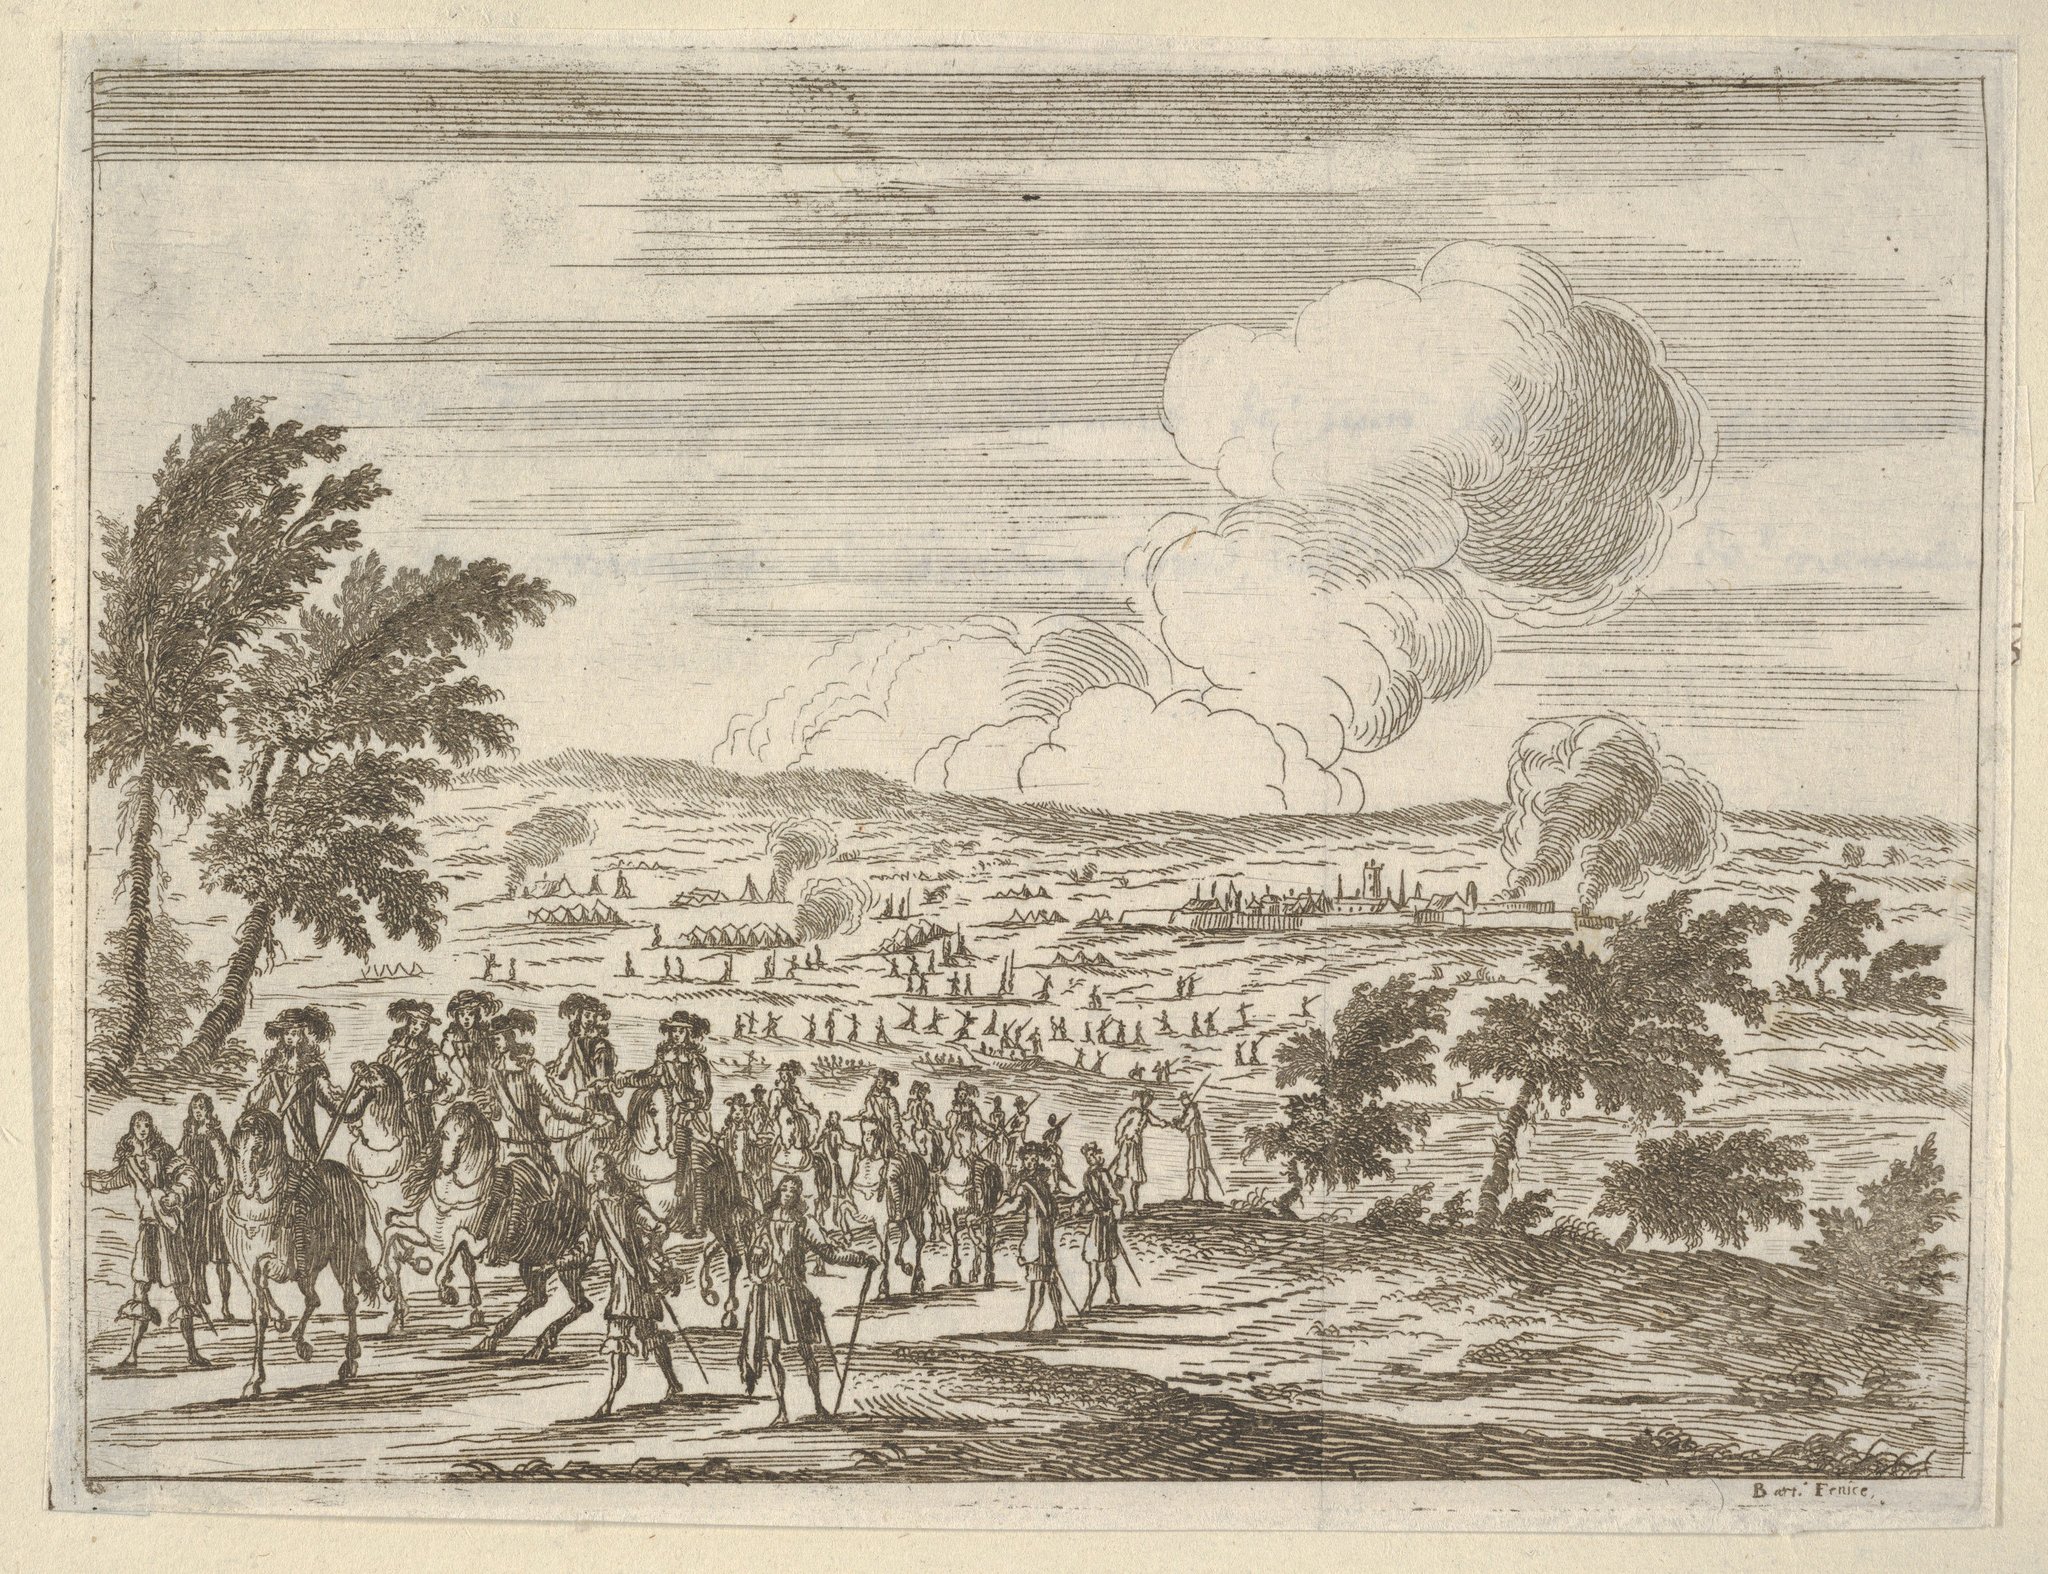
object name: print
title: The Duke and his troops at Casalmaggiore, from "L'Idea di un Principe ed Eroe Cristiano in Francesco I d'Este, di Modena e Reggio Duca VIII [...]"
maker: bartolomeo fenice (fénis)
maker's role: artist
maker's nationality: italian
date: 1659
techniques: etching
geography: italy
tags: soldiers,men,horses